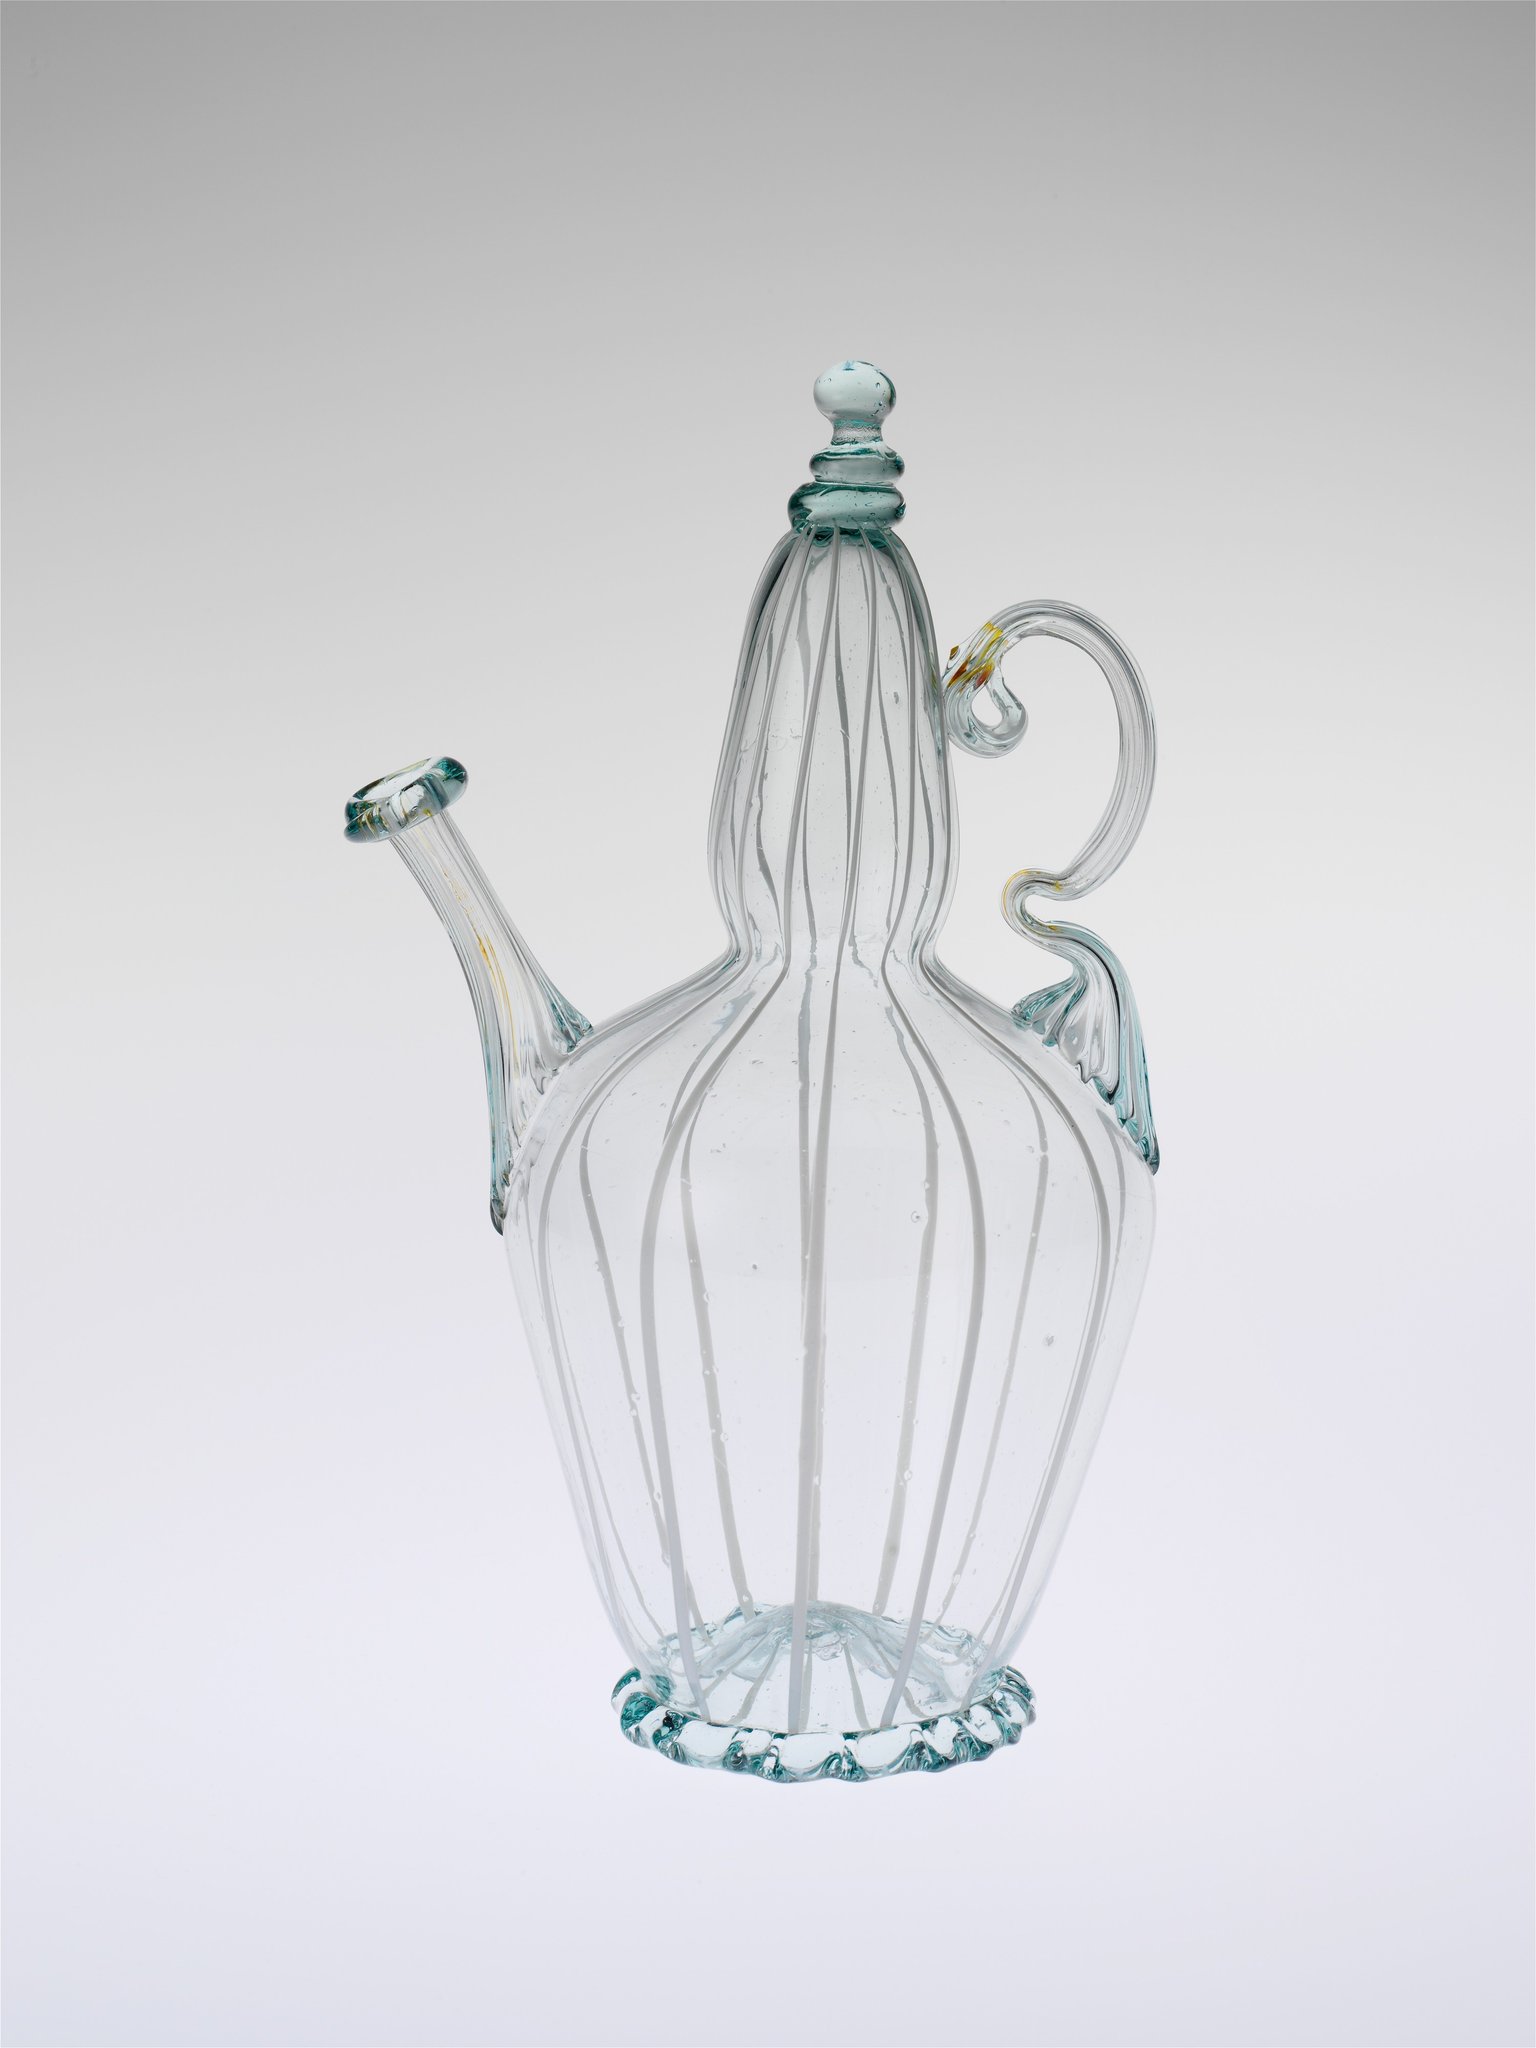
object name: cruet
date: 1601-1700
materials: glass